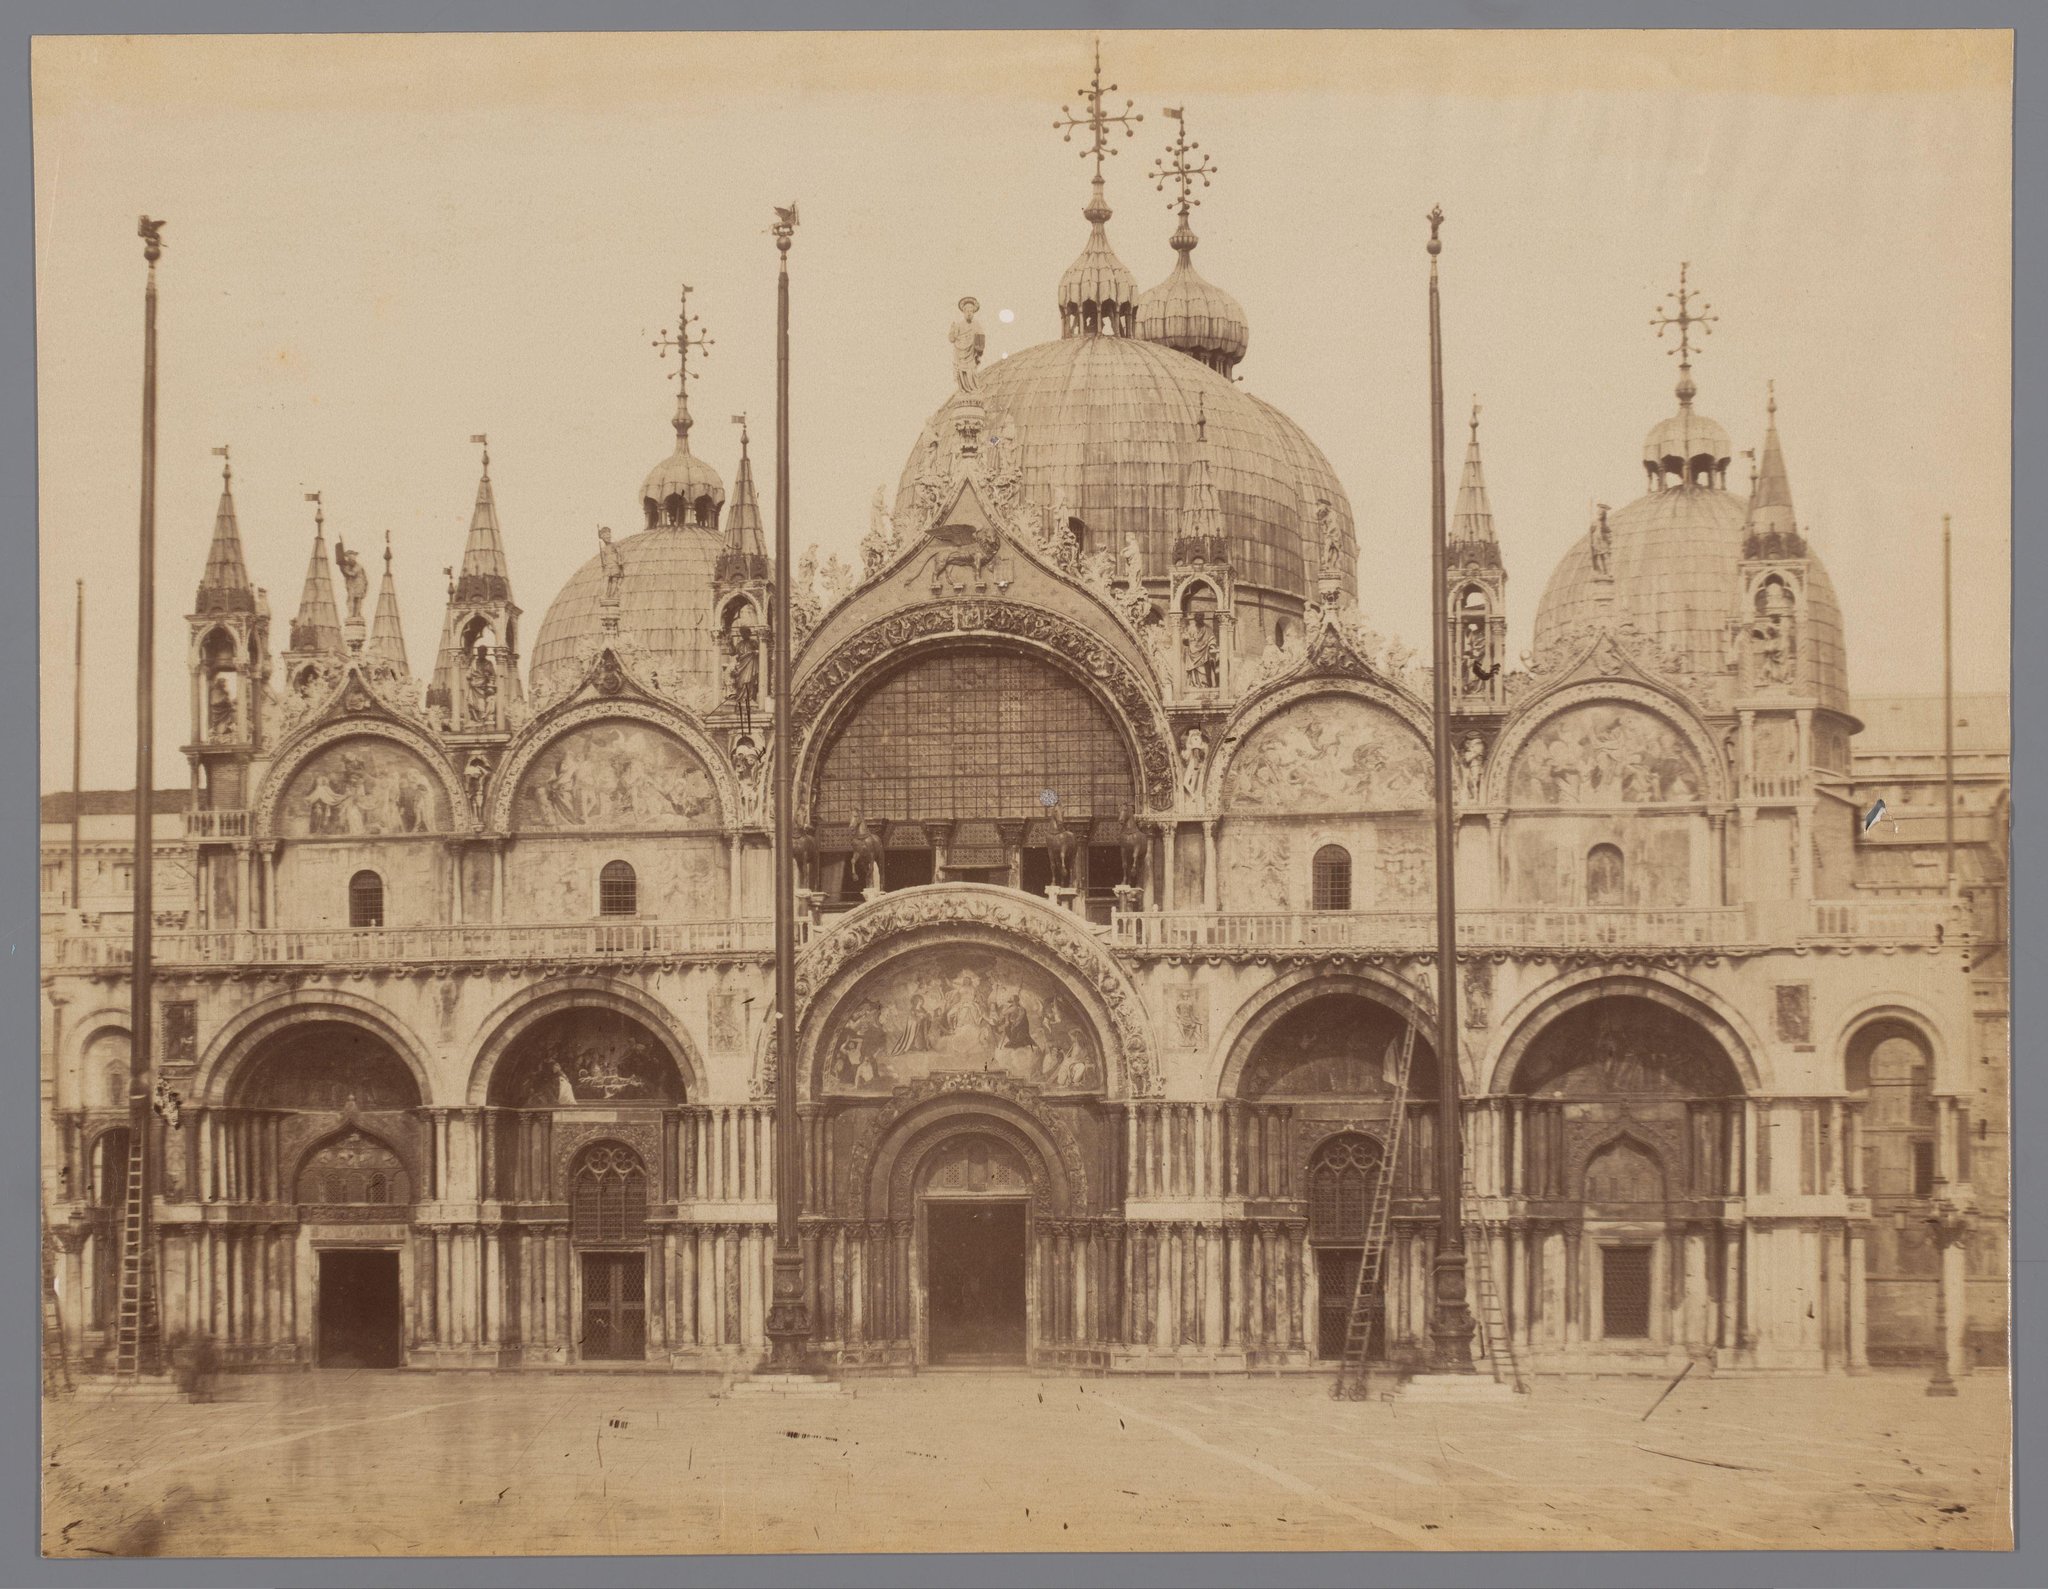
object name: photograph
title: Vooraanzicht San Marco, Venetië, Italië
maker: Anonymous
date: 1875-1900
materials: paper, photographic support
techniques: albumen print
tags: basiliek van san marco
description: Opvallend zijn de meerdere ladders die tegen de gevel zijn geplaatst. Renovatie?